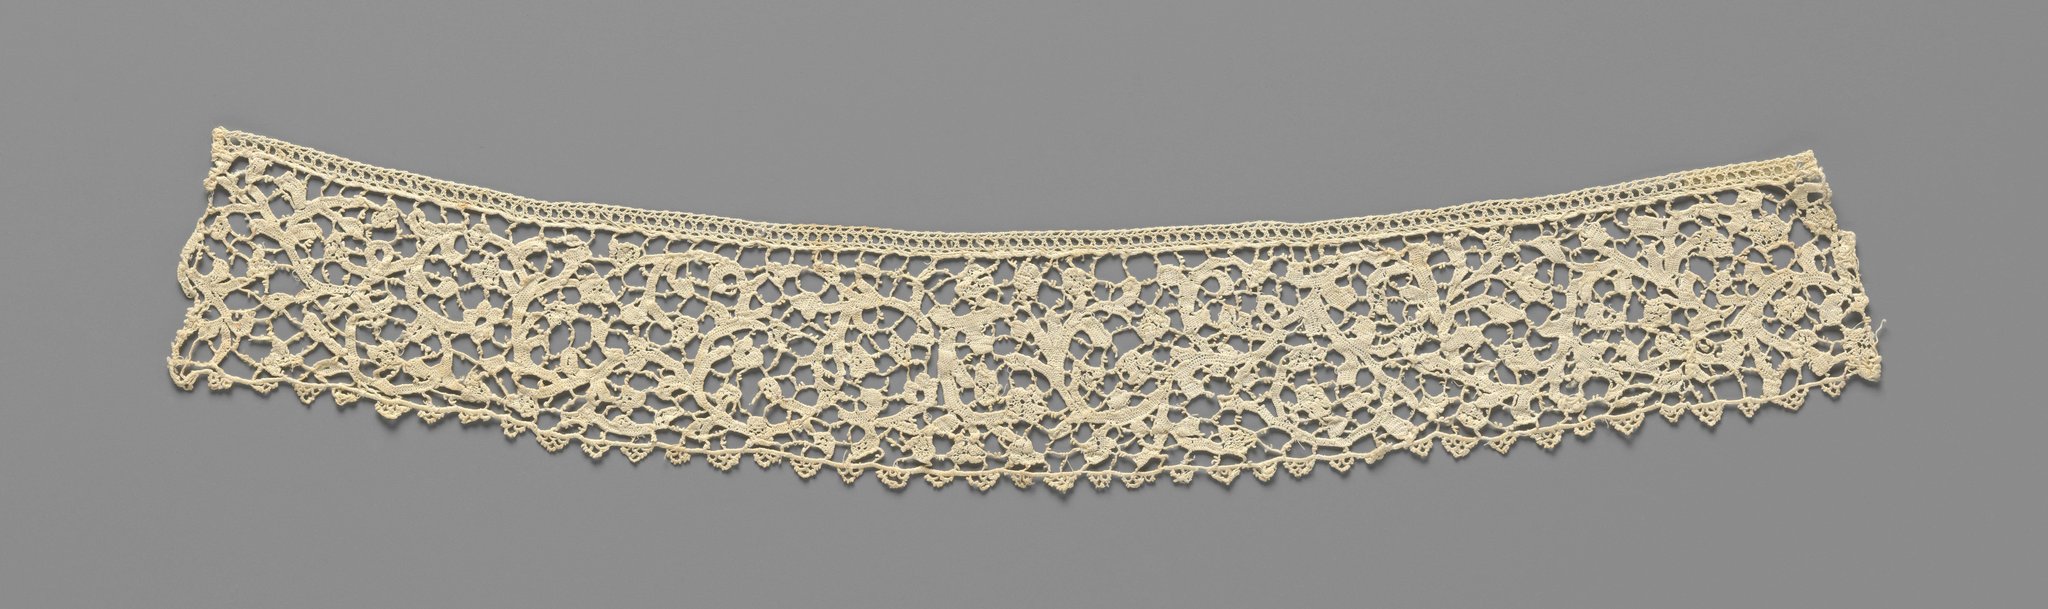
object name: strip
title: Strook naaldkant met c-vormige ranken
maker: Anonymous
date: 1700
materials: linen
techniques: flat venetian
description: Strook naturelkleurig naaldkant, Venise plat. Patroon met ranken en bescheiden vormgegeven bloemen. Verschillende c-vormige ranken die naast elkaar geplaatst zijn vallen op. Grond met onregelmatige gepicoteerde spijlen. De bovenzijde is afgezet met een rand kloskant. De onderzijde is afgewerkt met een picotrand met driehoekjes.